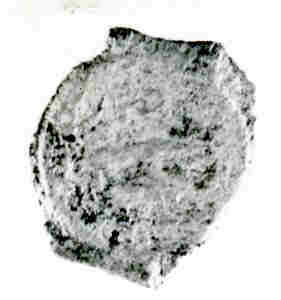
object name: coin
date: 701-900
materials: copper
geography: iran